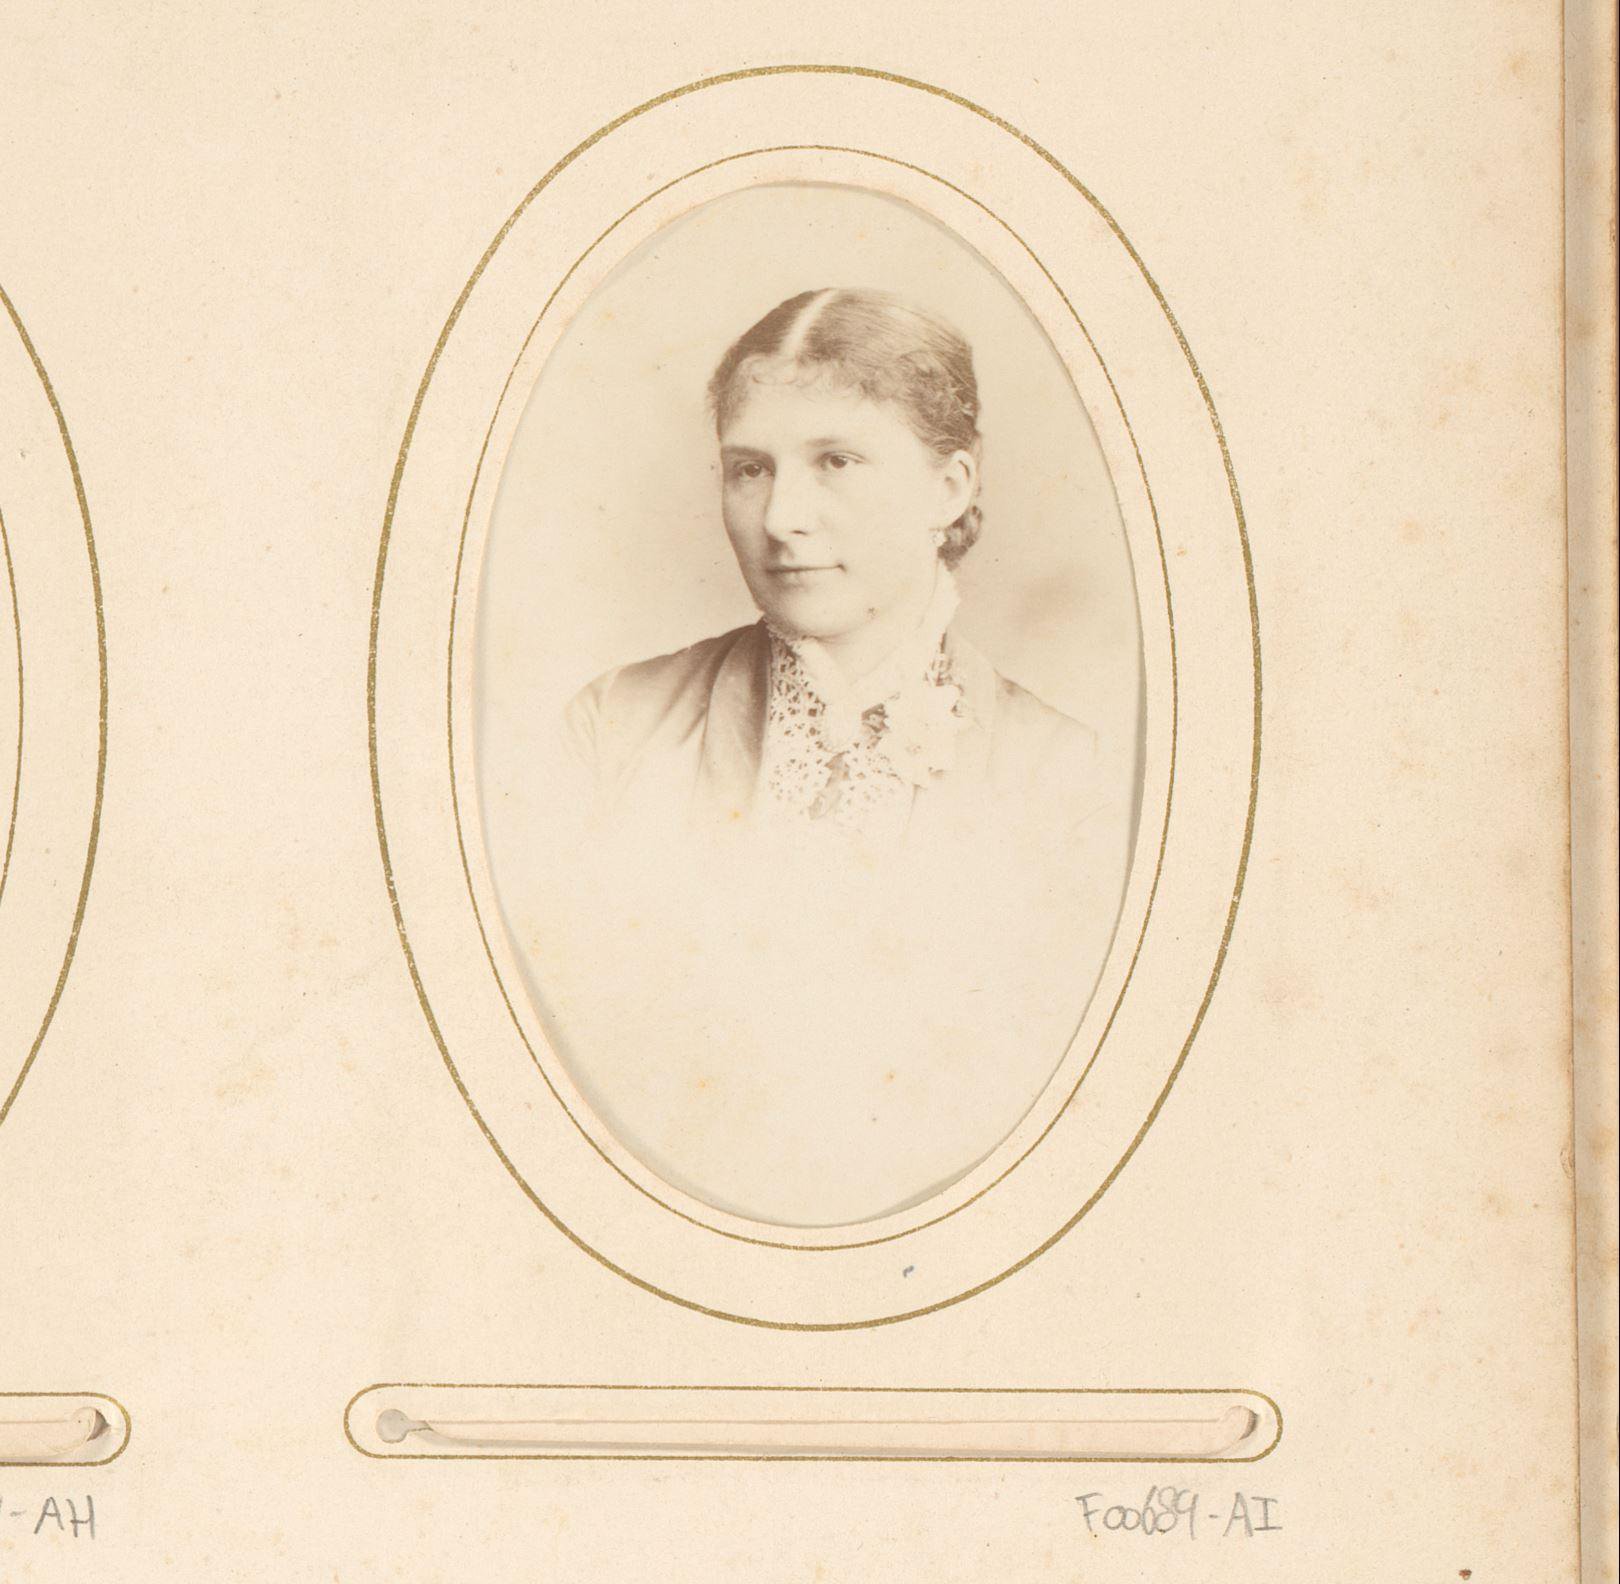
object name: carte de visite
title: Portret van een vrouw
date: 1860-1895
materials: cardboard, photographic support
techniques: albumen print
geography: england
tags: historical persons - bb - woman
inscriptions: inscription: ‘Negative No. 22997/ Position No. 3’, inscription: ‘Hills & Saunders/ Photogrpahers/ London (...)’